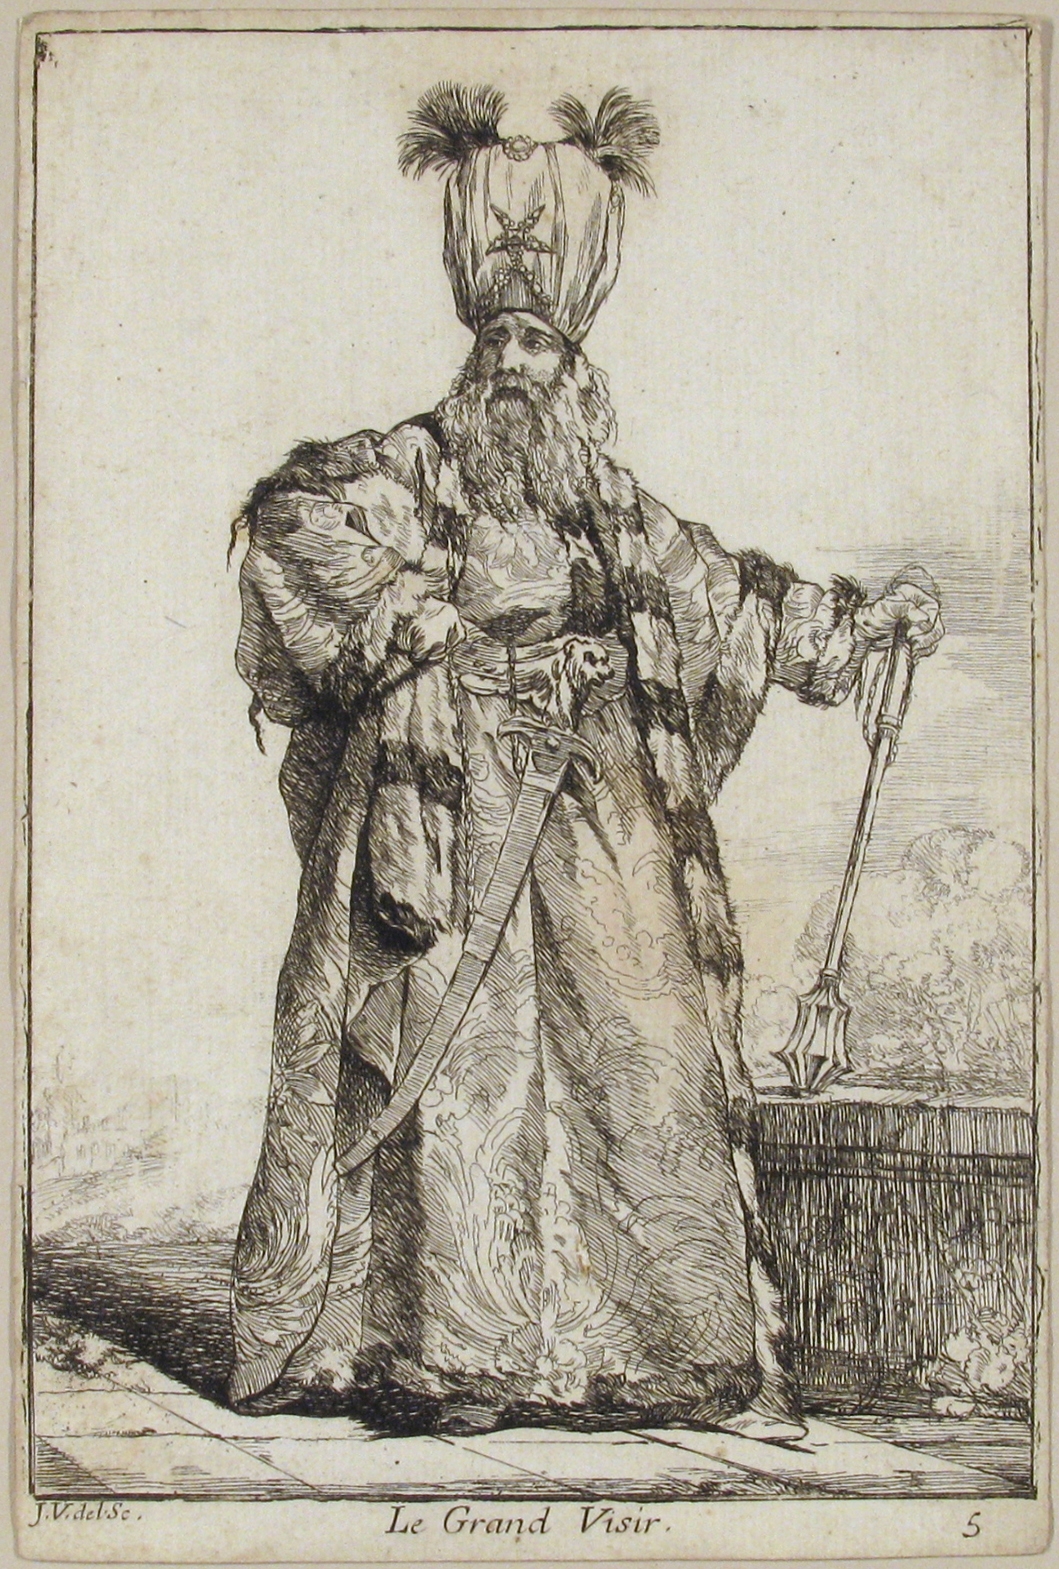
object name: print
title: Le Grand Visir (The Grand Vizir), from the series "Caravane du Sultan à la Mecque..." (Caravan of a Sultan Going to Mecca)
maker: joseph marie vien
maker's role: artist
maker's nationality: french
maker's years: 1716-1809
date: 1748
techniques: etching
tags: swords,men